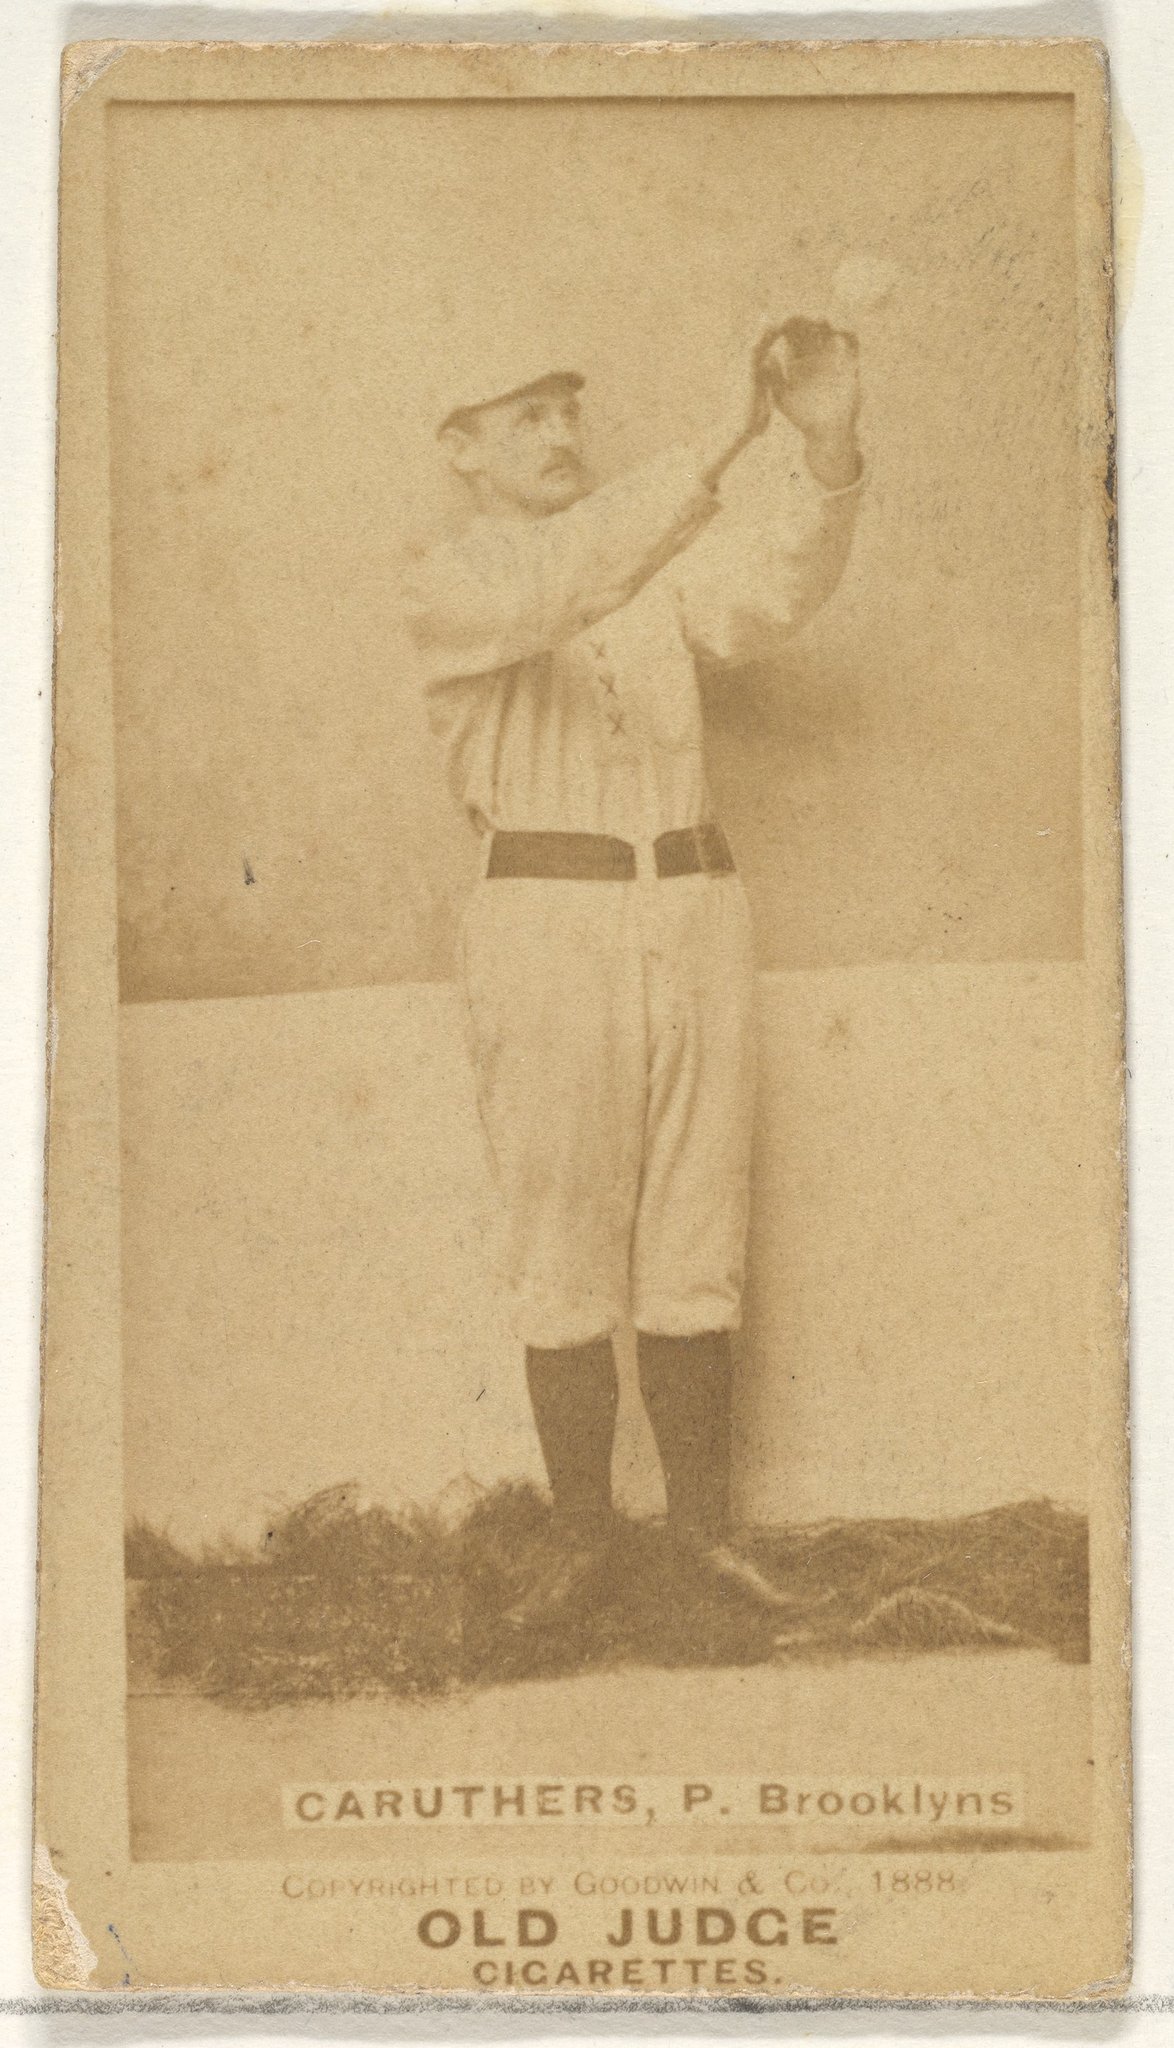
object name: baseball card, photograph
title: Caruthers, Pitcher, Brooklyn, from the Old Judge series (N172) for Old Judge Cigarettes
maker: goodwin & company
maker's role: publisher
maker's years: 1850-1950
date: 1888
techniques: albumen silver print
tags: men,portraits,baseball,athletes